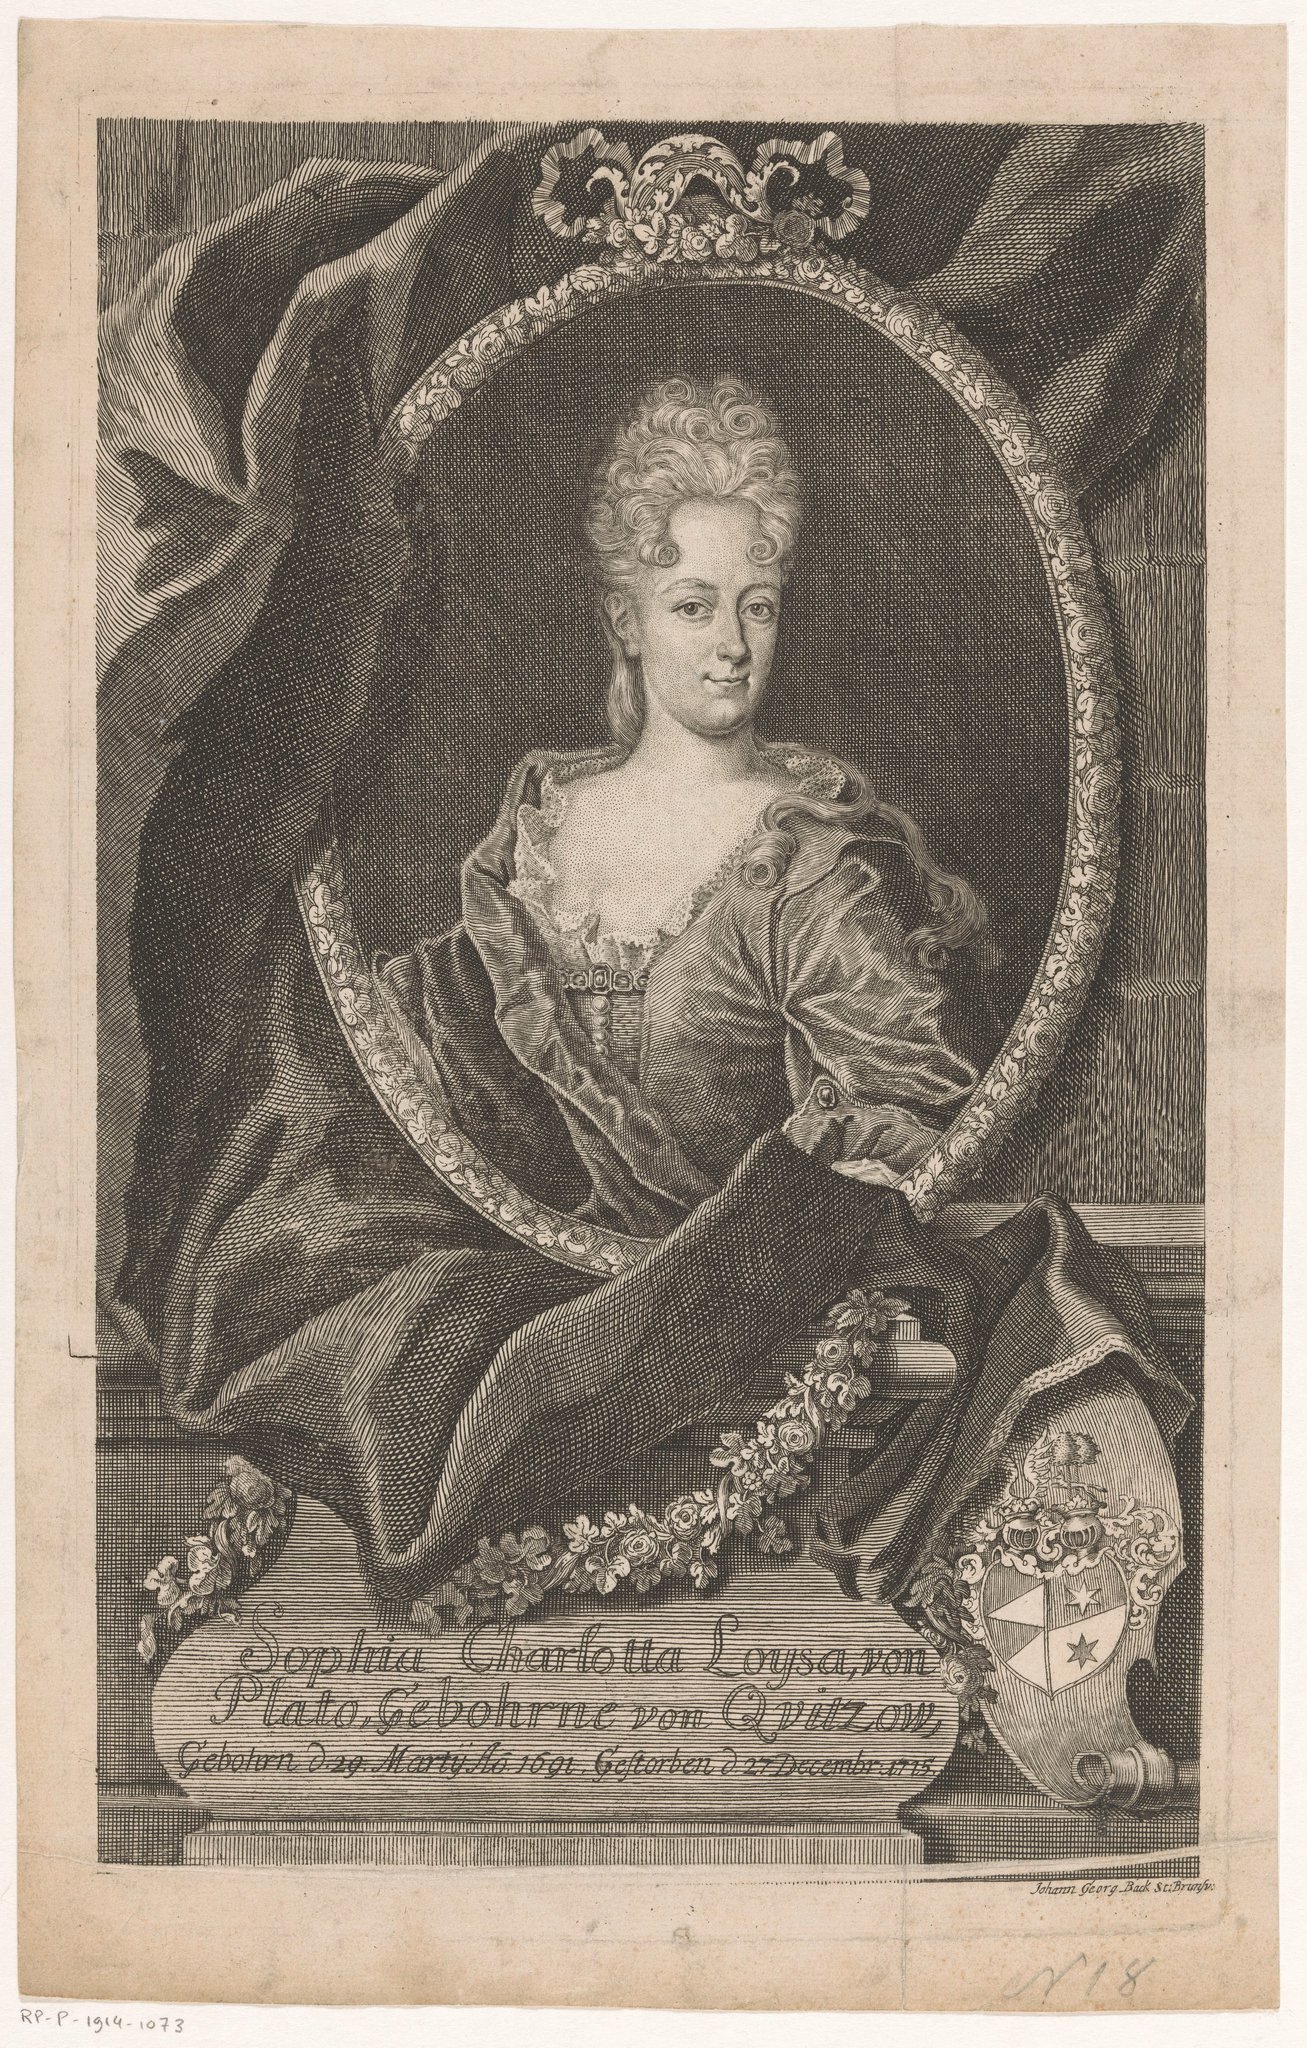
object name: print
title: Portret van Sophie Charlotte Luise von Plato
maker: johann georg beck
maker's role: print maker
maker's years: 1676-1722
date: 1715-1732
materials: paper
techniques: engraving, etching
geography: braunschweig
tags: historical persons - bb - woman, armorial bearing, heraldry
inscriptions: collector's mark: Lugt 2228